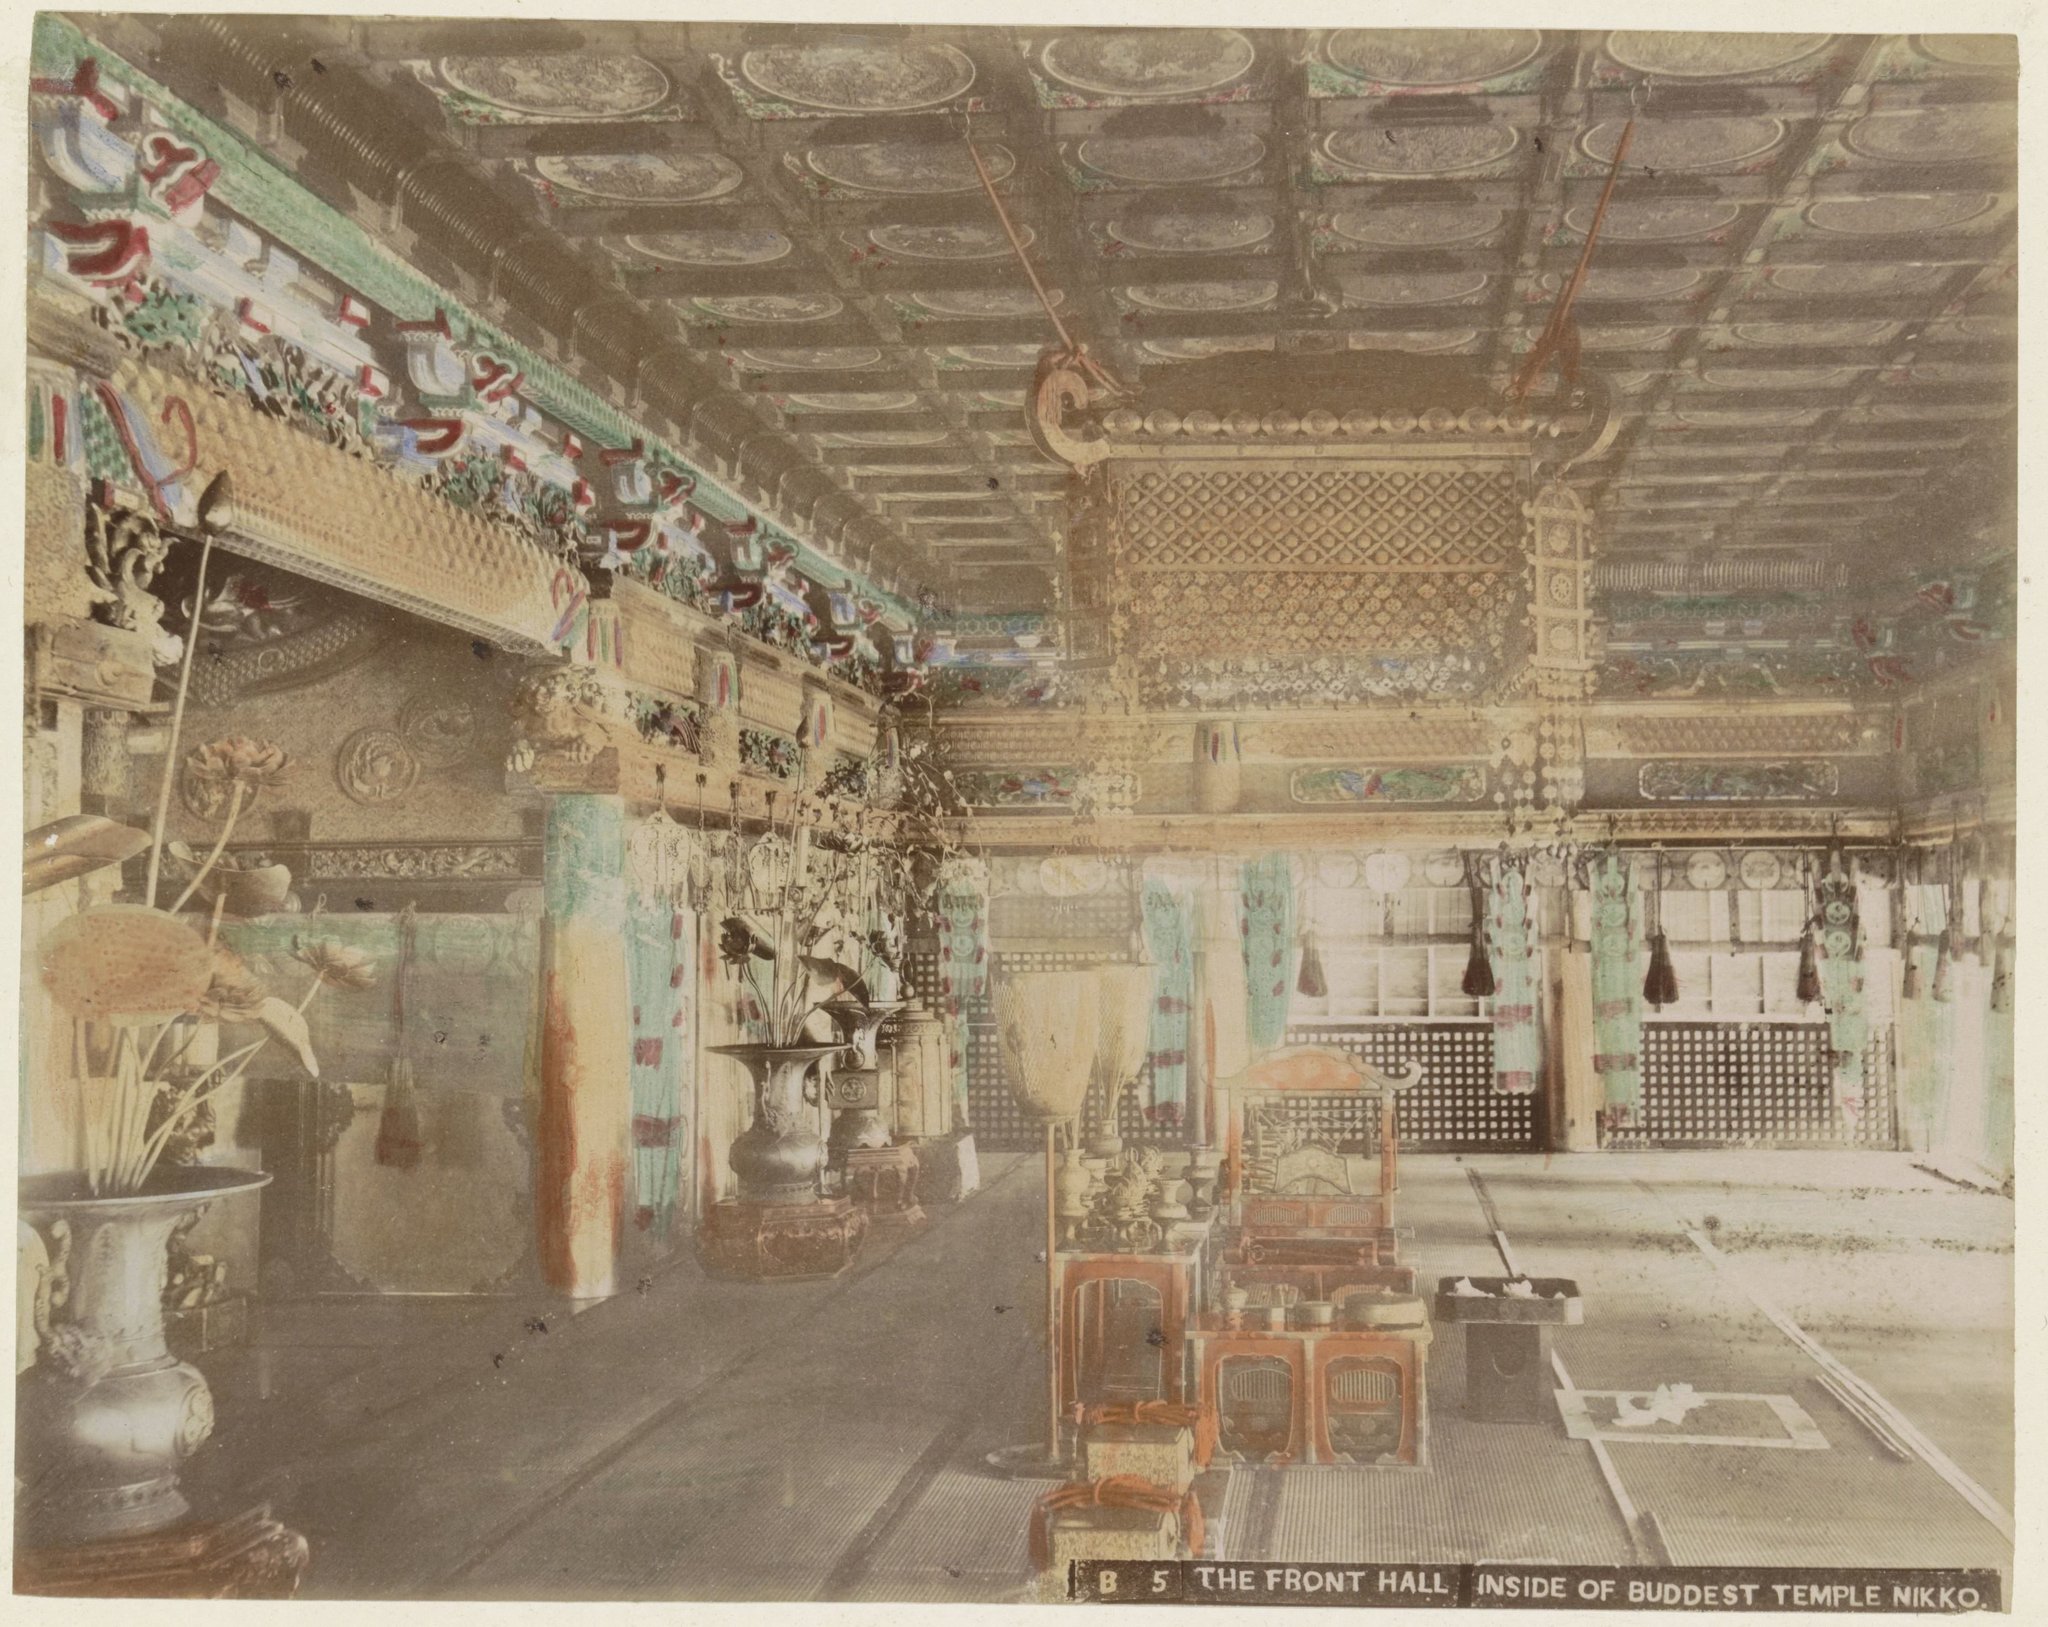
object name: photograph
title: Interieur van de voorhal van de Rinnoji-tempel in Nikko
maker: Anonymous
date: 1870-1900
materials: cardboard, paper, photographic support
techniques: albumen print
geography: nikko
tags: temple, shrine ~ hinduism, buddhism, jainism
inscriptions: negative number: ‘B 5’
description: Onderdeel van Reisalbum met foto's van bezienswaardigheden in Japan.